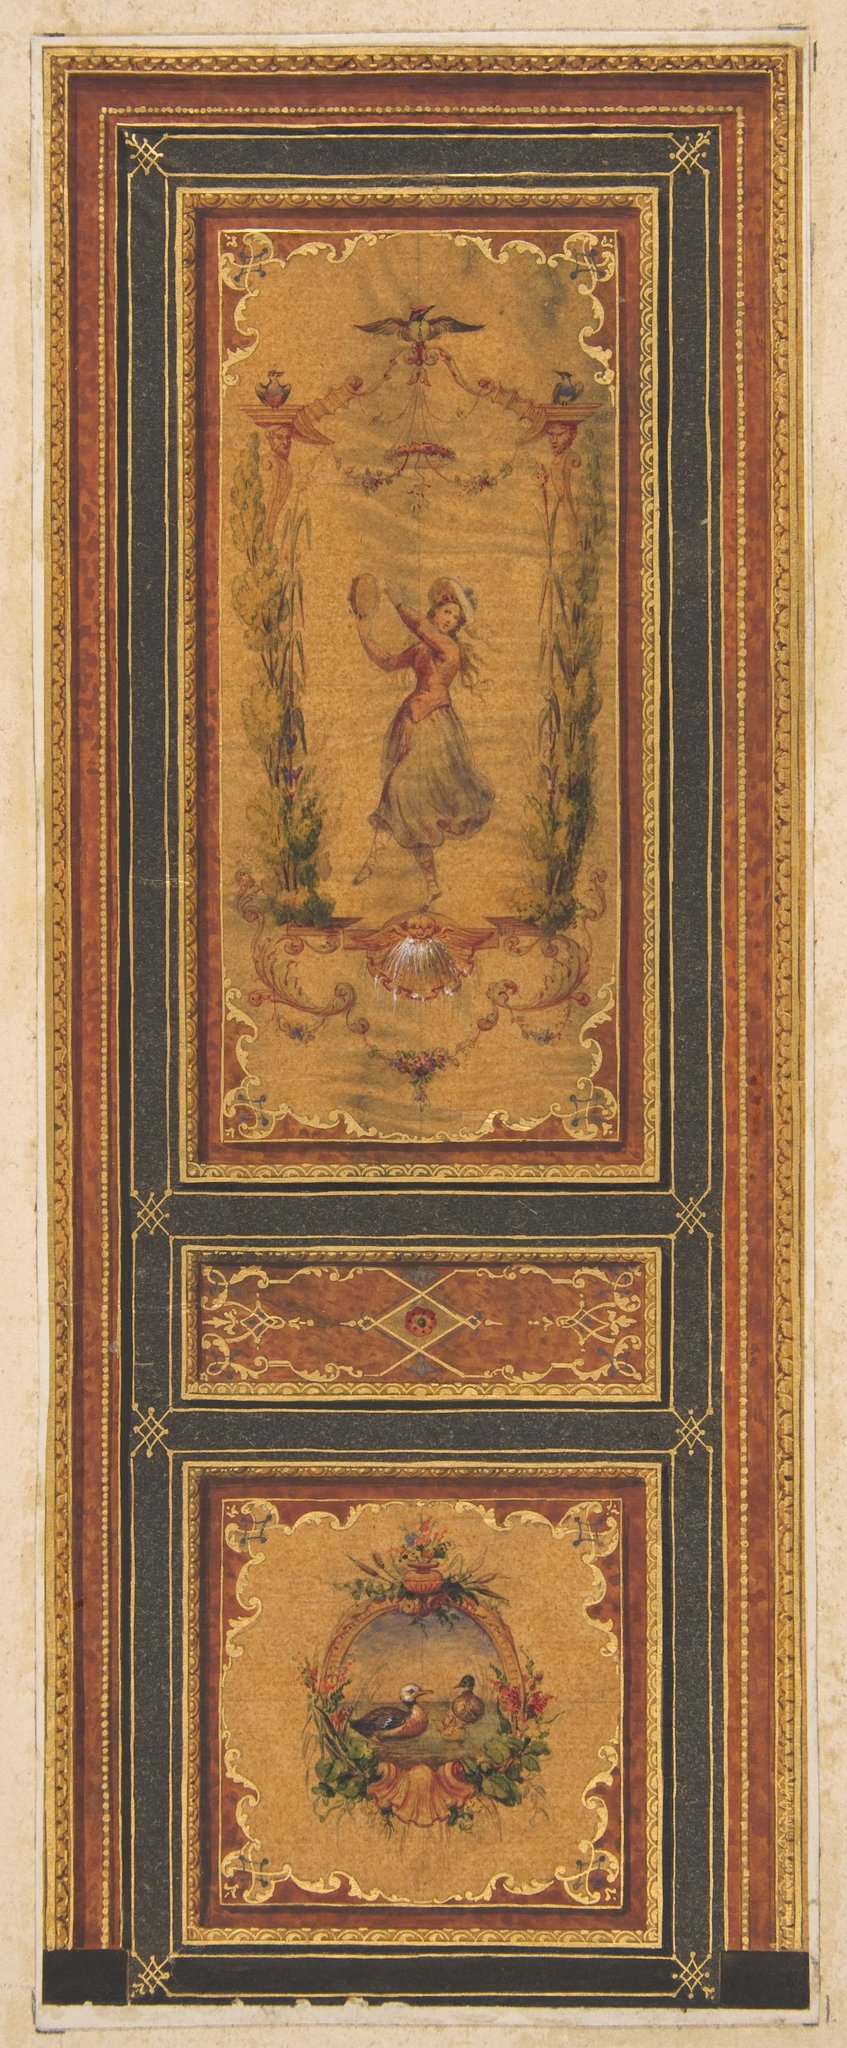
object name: drawing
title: Design for a decorated door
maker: jules-edmond-charles lachaise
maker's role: artist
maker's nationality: french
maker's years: 1897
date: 1830-1897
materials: gold paint, graphite, ink, watercolor, paper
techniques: pen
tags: birds,ducks,architecture,women